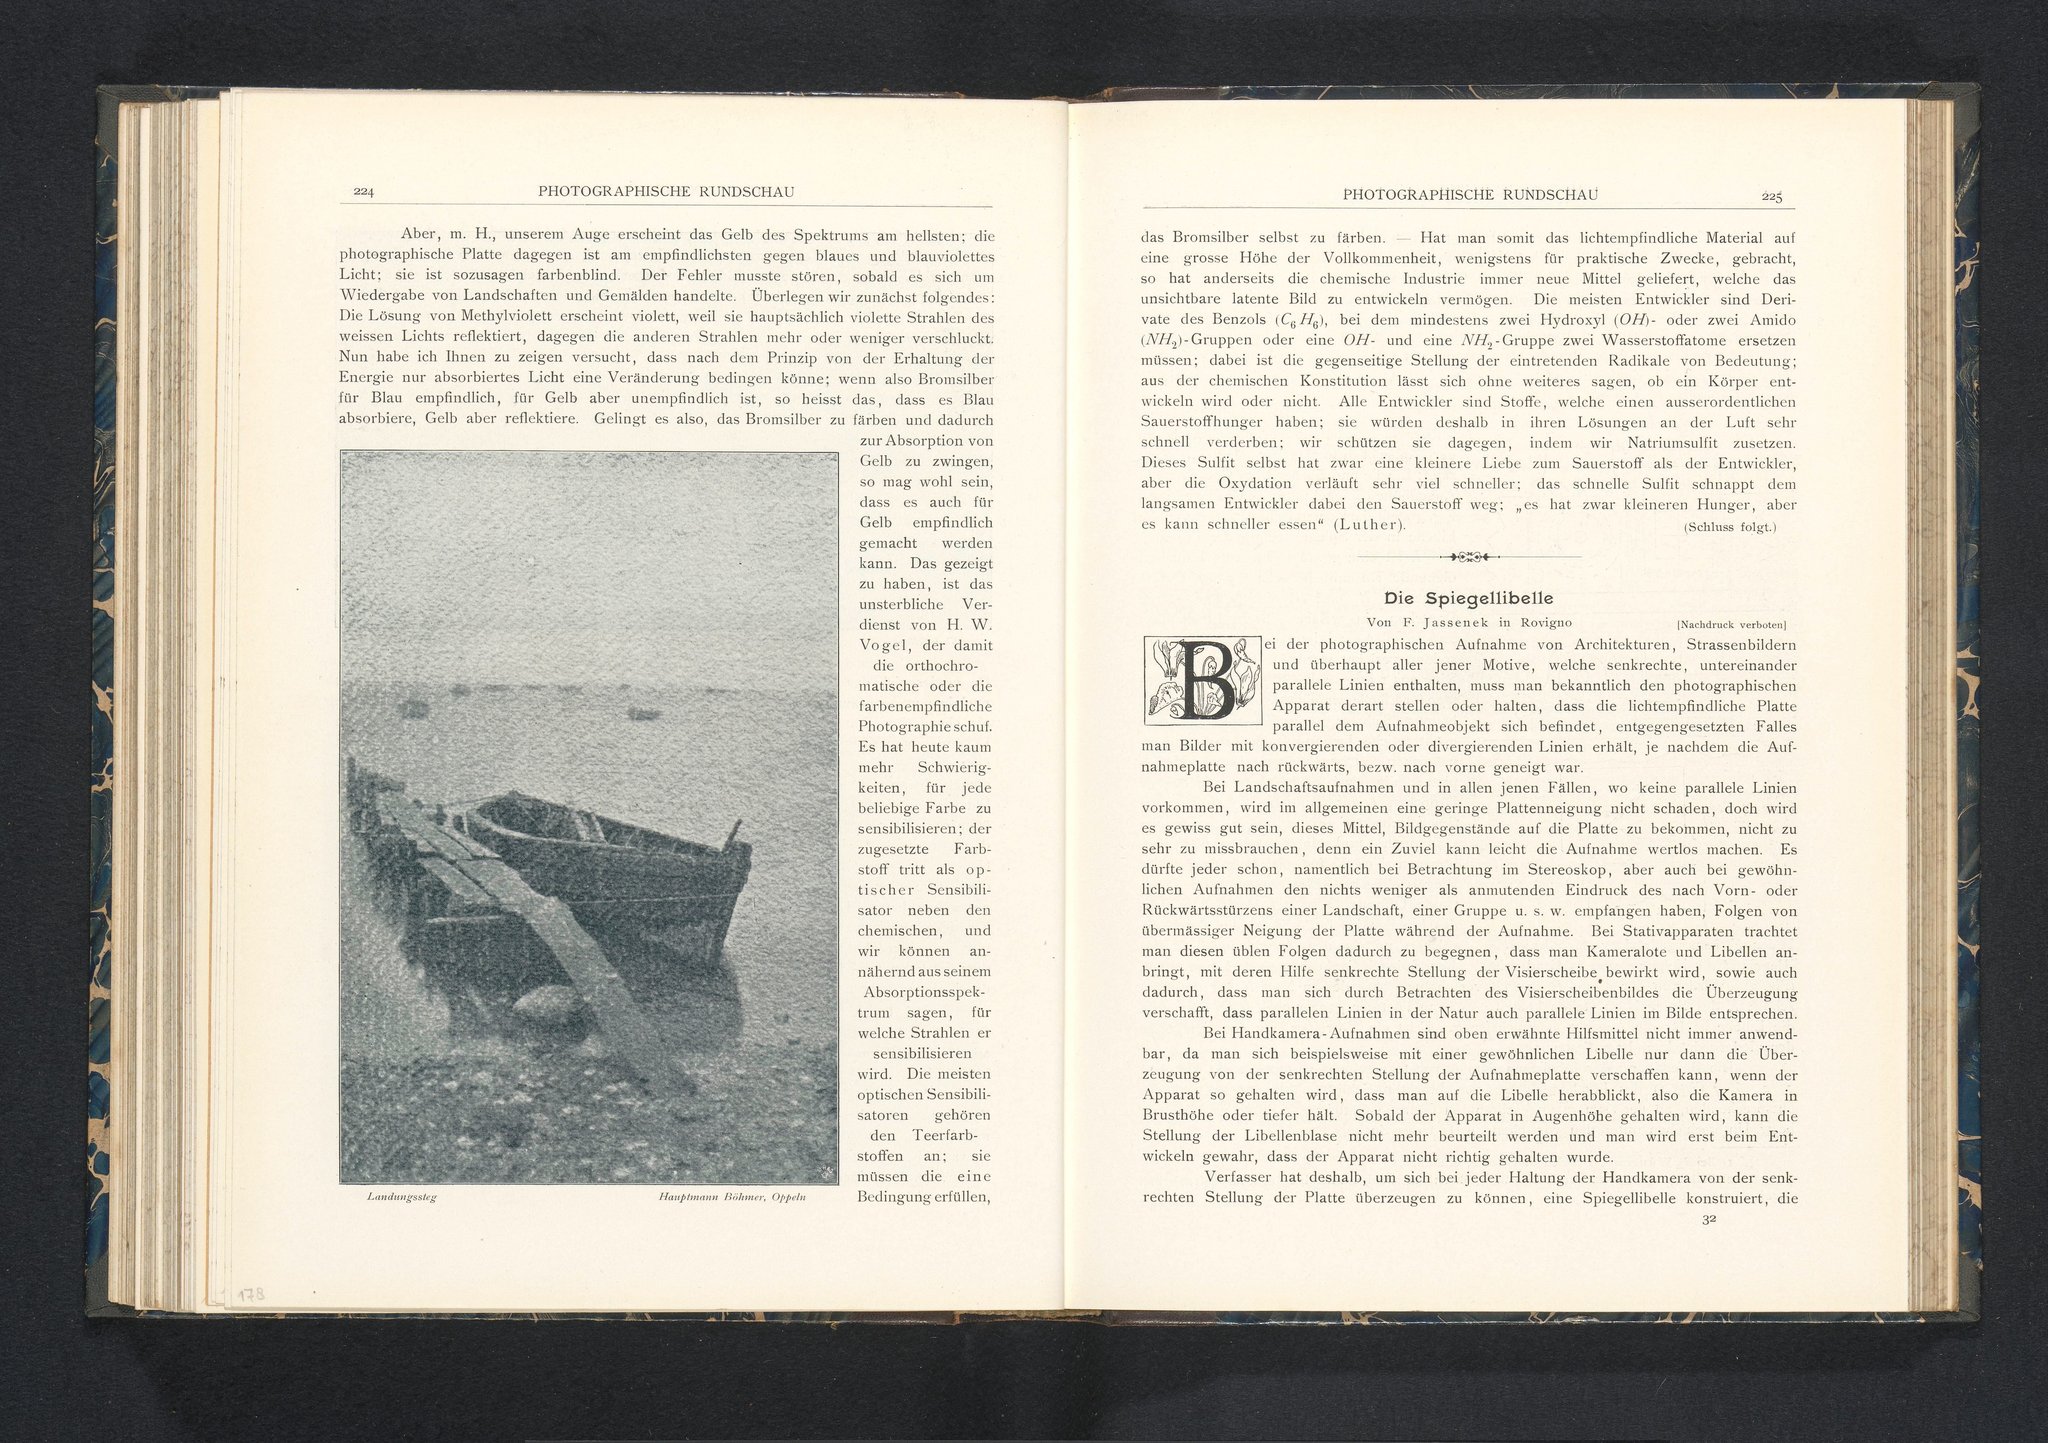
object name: photomechanical print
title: Landungssteg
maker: hauptmann a. böhmer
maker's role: draughtsman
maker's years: 1860-1908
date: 1896-1901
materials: paper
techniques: autotype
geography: berlin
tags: rowing-boat, canoe, etc., pier, quay, wharf